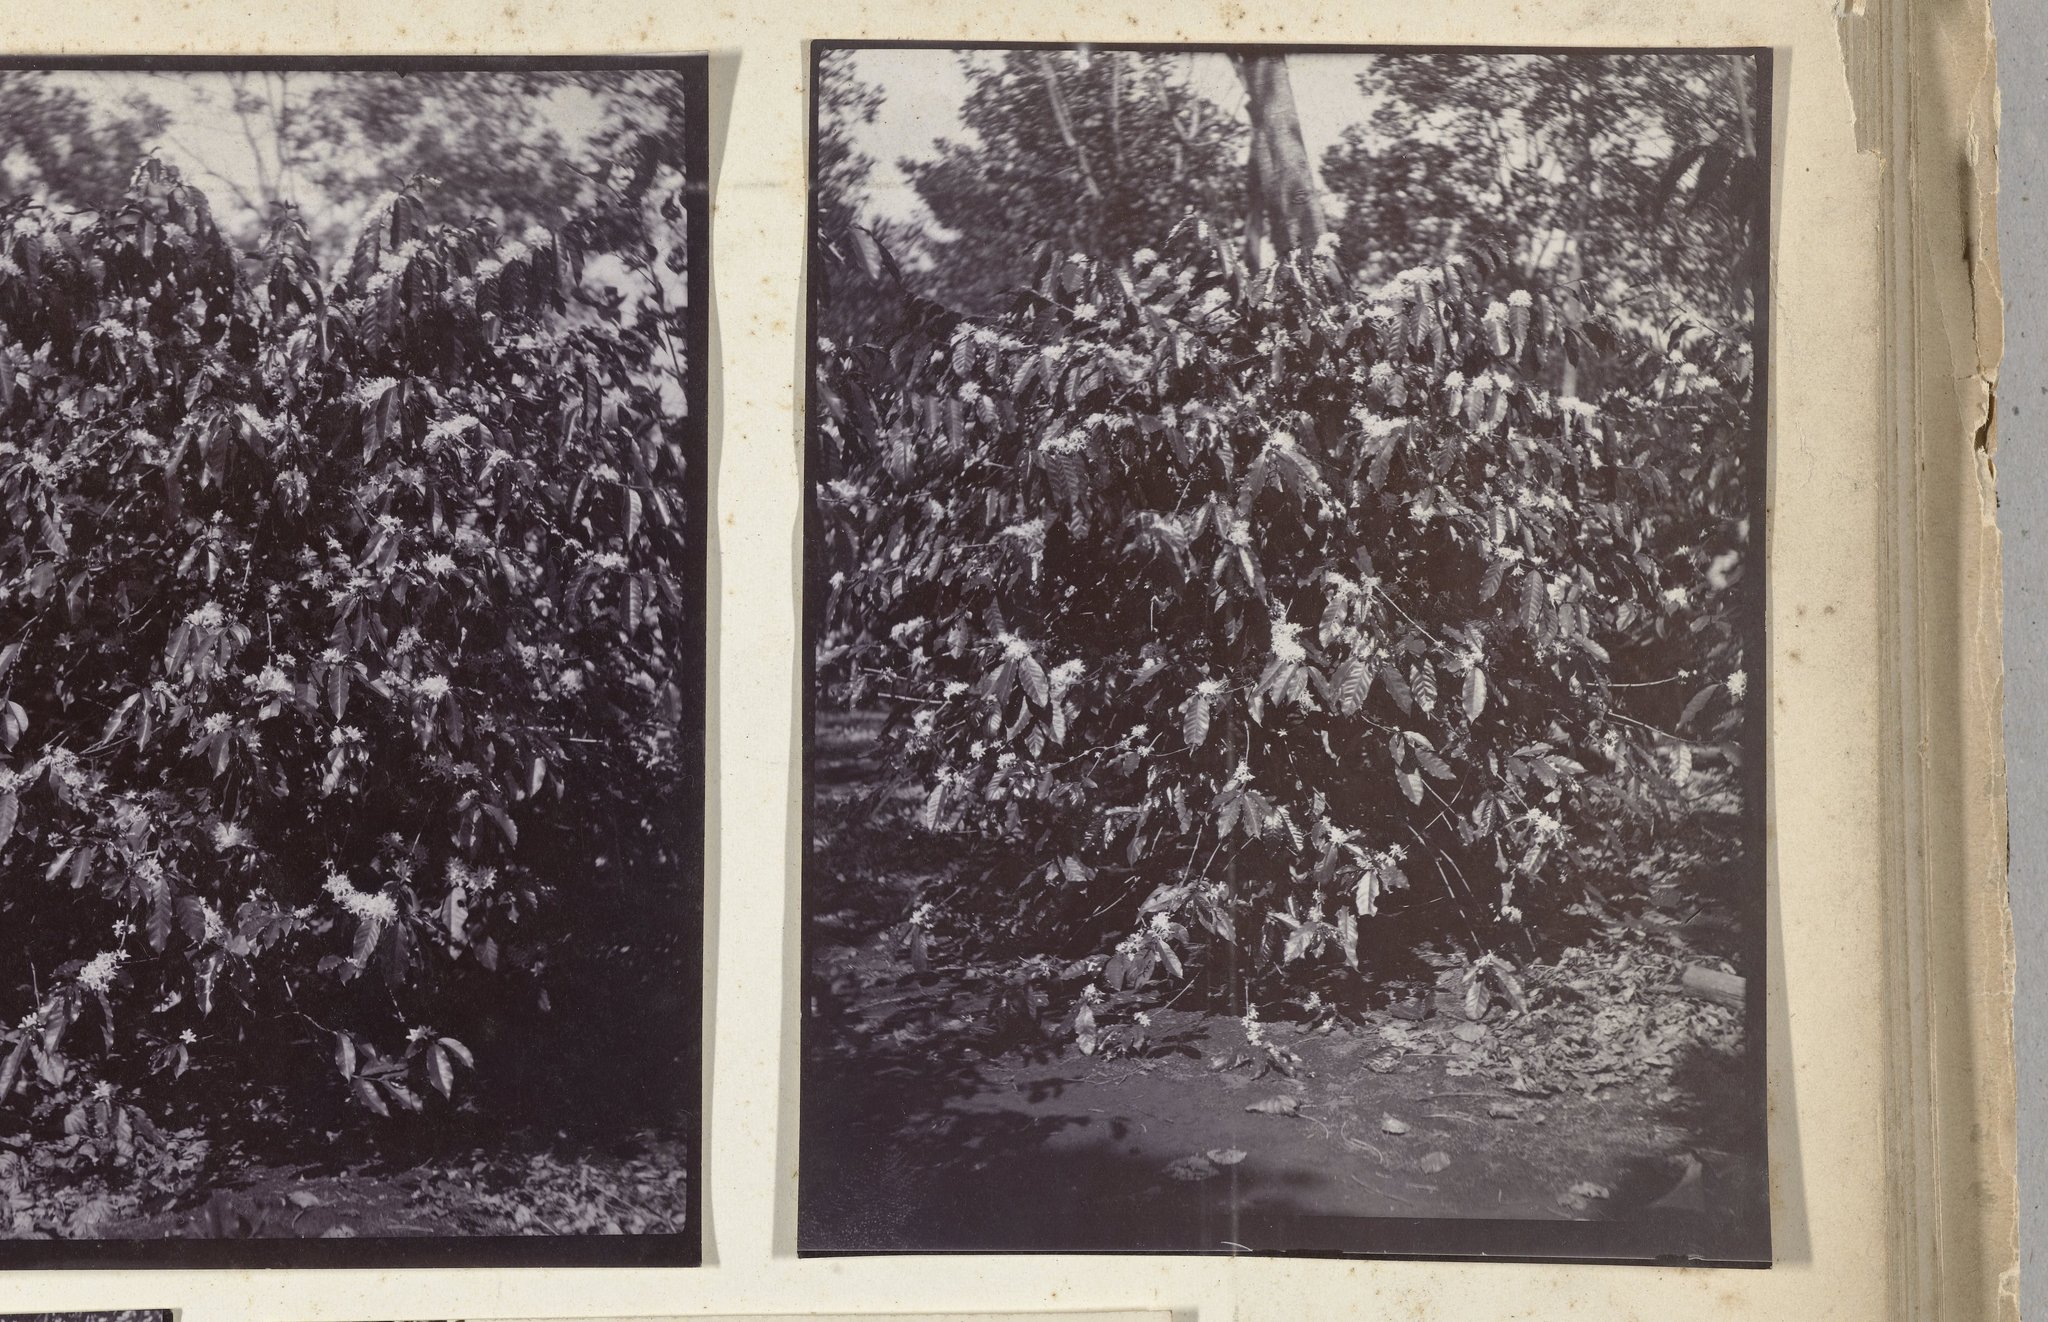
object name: photograph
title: Koffietuinen van Silo Sanen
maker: Anonymous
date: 1890-1910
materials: cardboard, paper, photographic support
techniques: gelatin silver print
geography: netherlands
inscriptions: caption: ‘Koffietuinen van Silo Sanen’